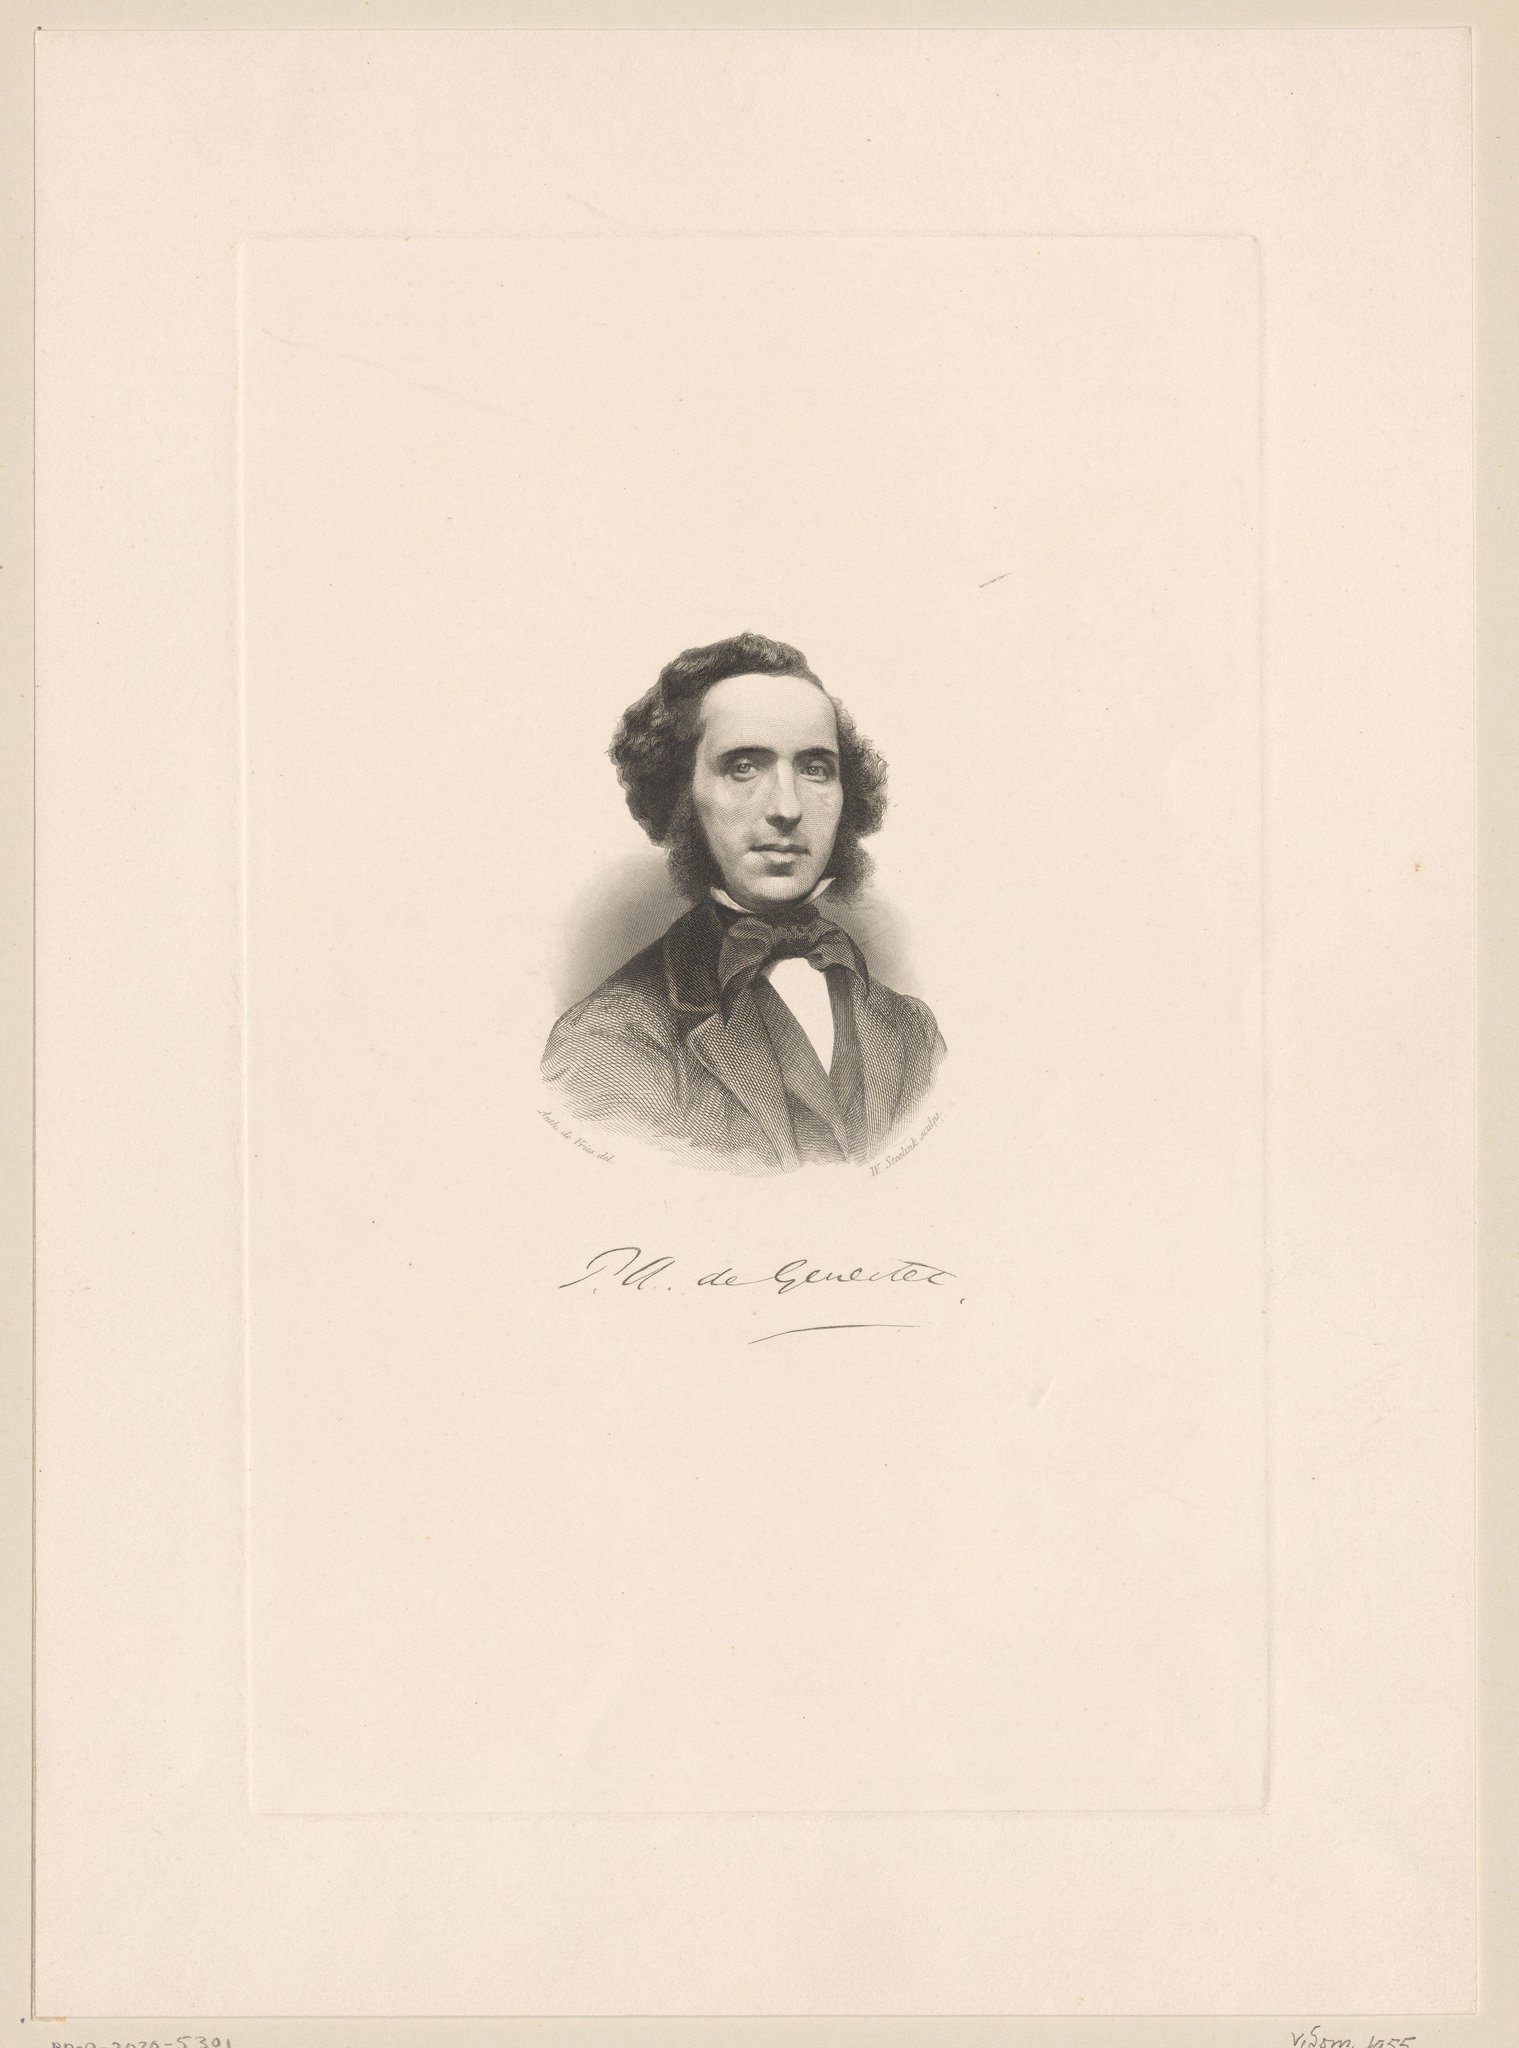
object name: book illustration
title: Portret van Petrus Augustus de Génestet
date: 1869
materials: paper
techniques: engraving, etching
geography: amsterdam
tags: petrus augustus de génestet, historical persons, writer, poet, author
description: Prent uit: De dichtwerken van P.A. de Génestet verzameld en uitgegeven onder toezicht van C.P. Tiele. 2 dln. Amsterdam: Gebroeders Kraay, 1869.